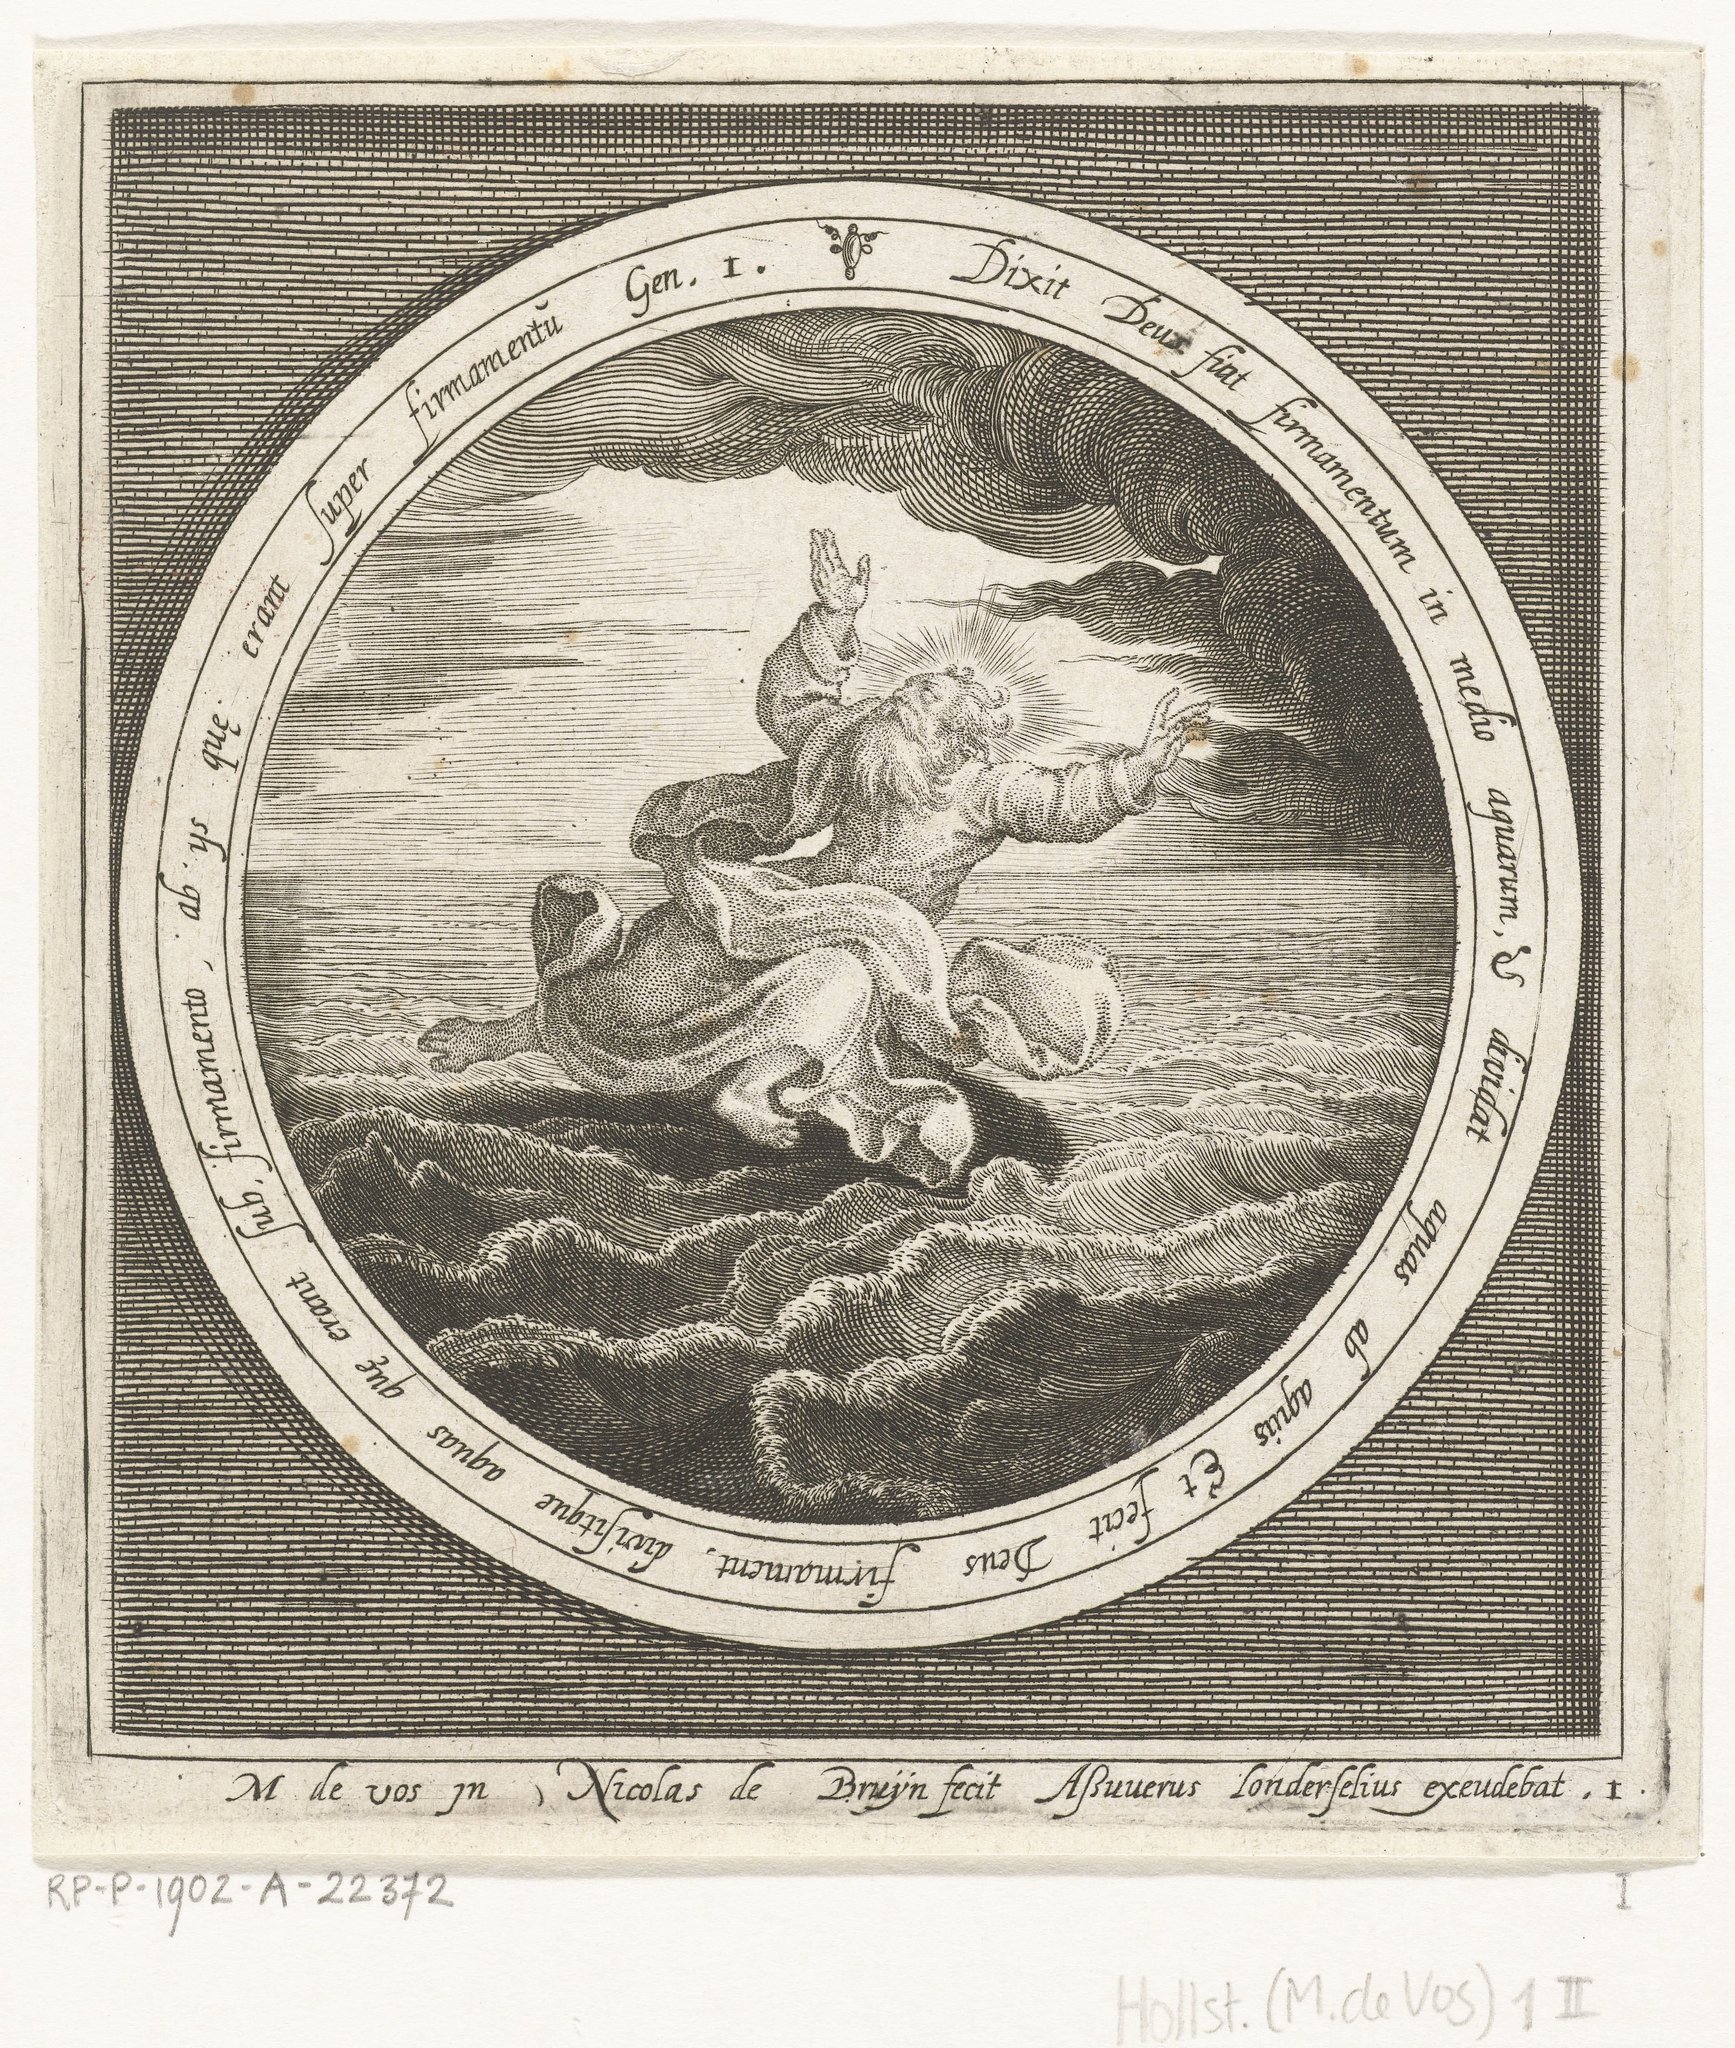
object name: print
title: Tweede dag van schepping: God scheidt de watermassa's in hemel en zee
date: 1581-1656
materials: paper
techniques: engraving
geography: netherlands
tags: creation of the firmament and division of the waters above and below it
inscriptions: collector's mark: Lugt 2542, collector's mark: Lugt 2228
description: Tweede dag van schepping: God scheidt de watermassa's in hemel en zee. In medaillon met als opschrift een bijbeltekst in Latijn uit Genesis 1, binnen rechthoekige omlijsting.